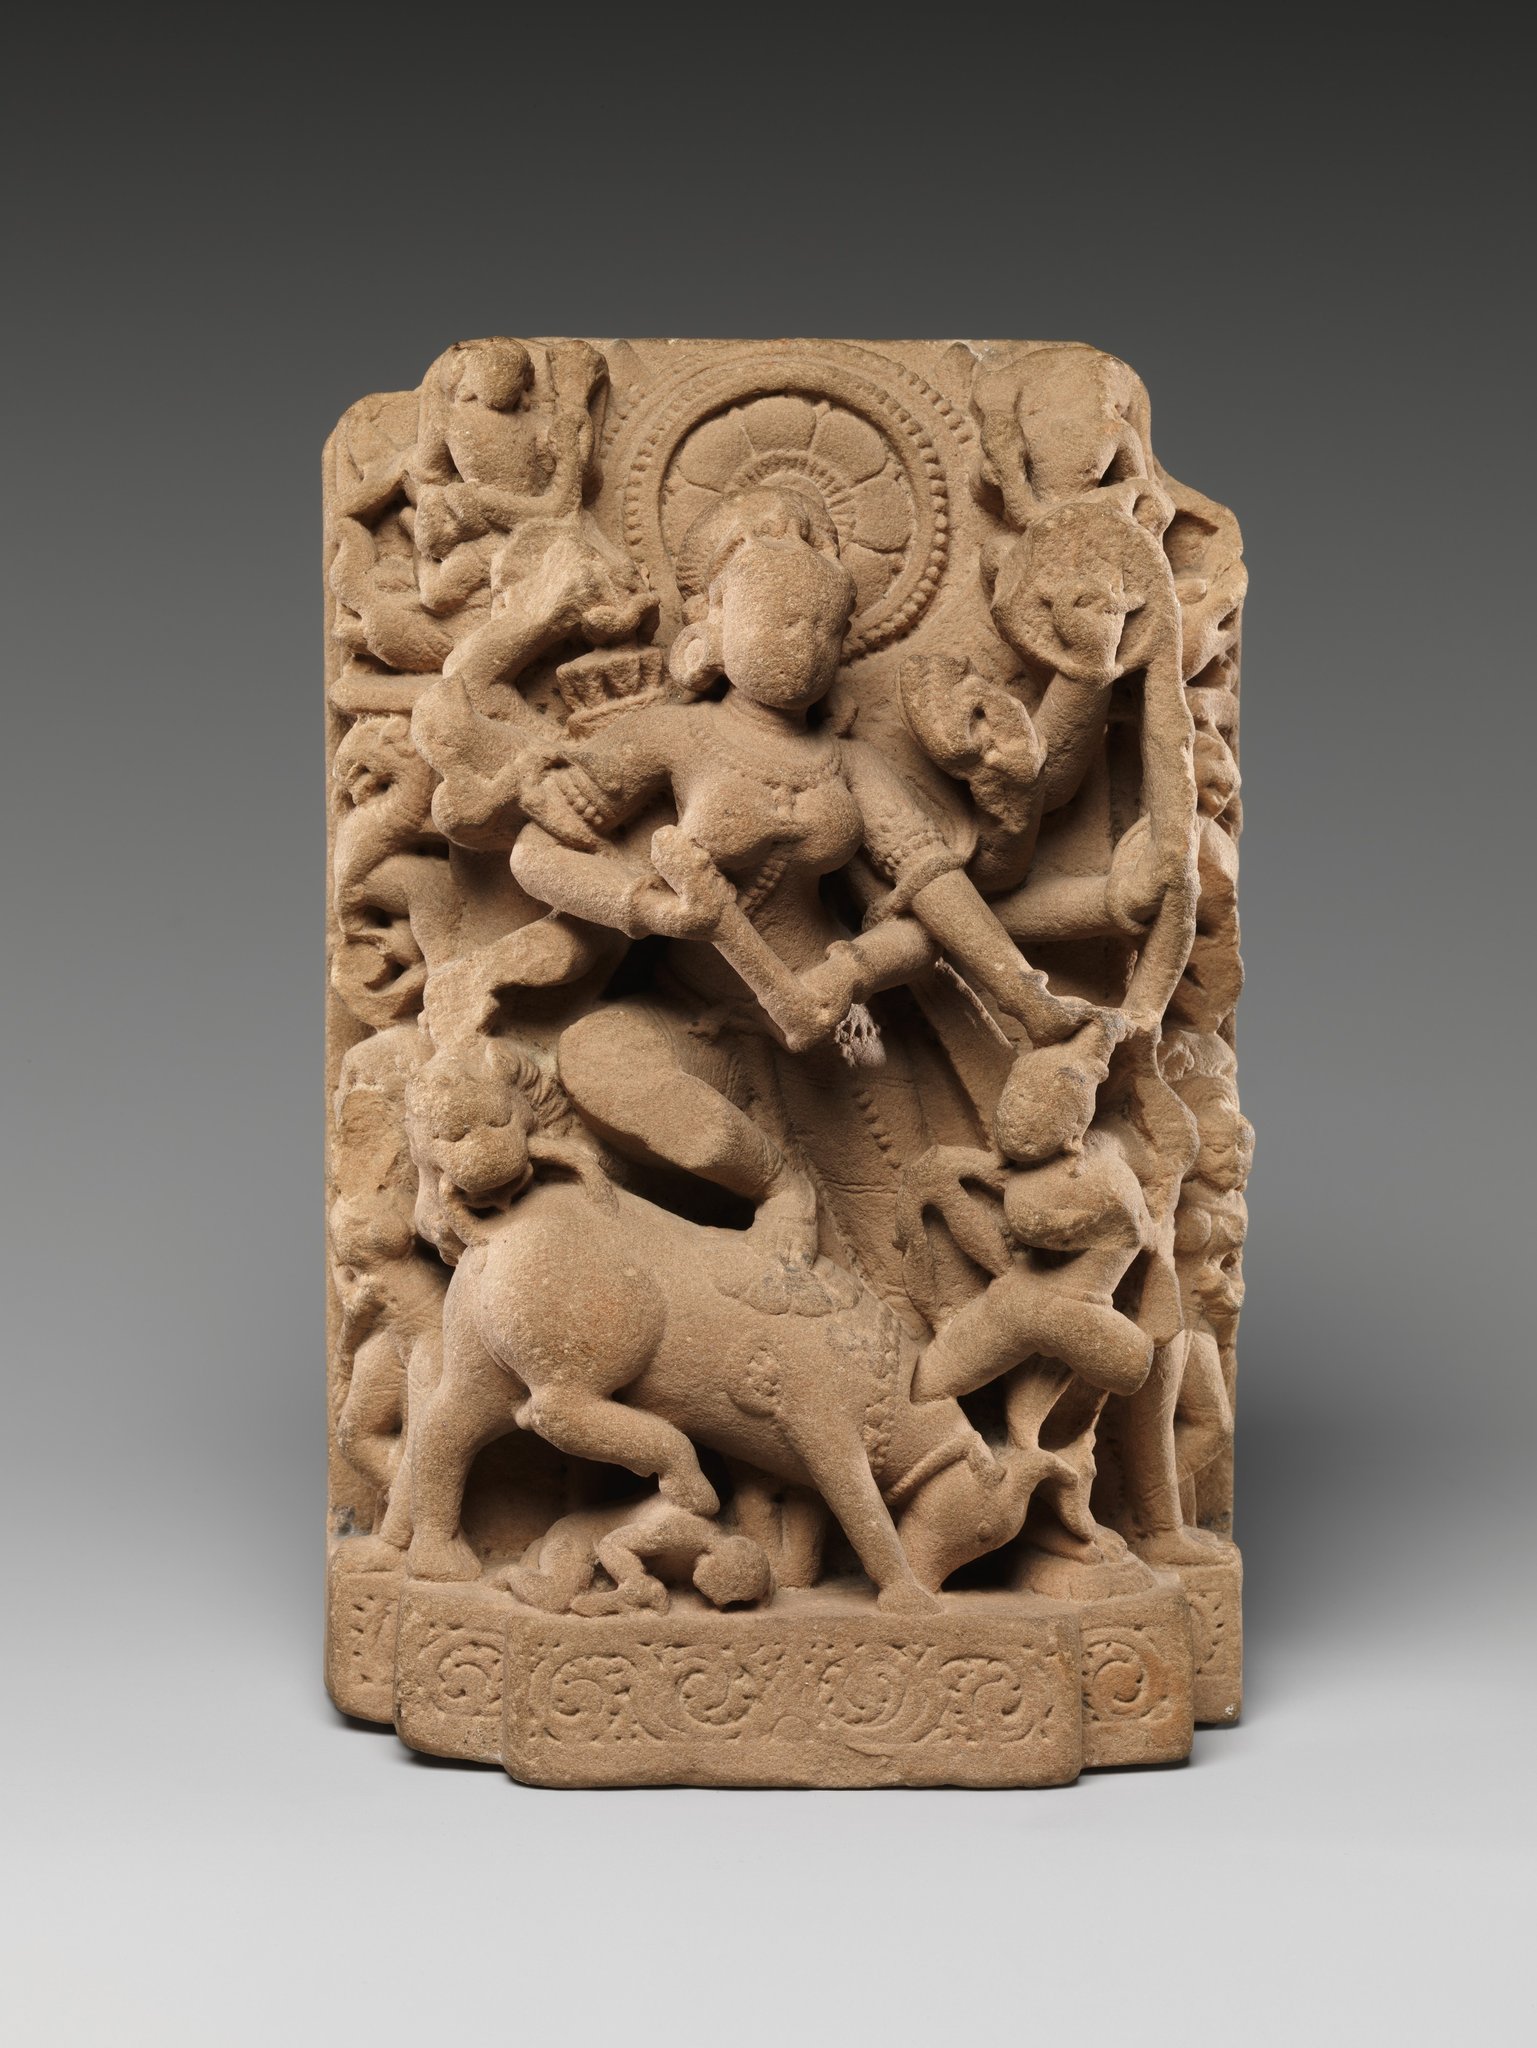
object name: figure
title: The Goddess Durga Slaying the Buffalo Demon (Mahisasura Mardini)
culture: indian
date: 901-1000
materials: stone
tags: buffalos,demons,durga,hinduism